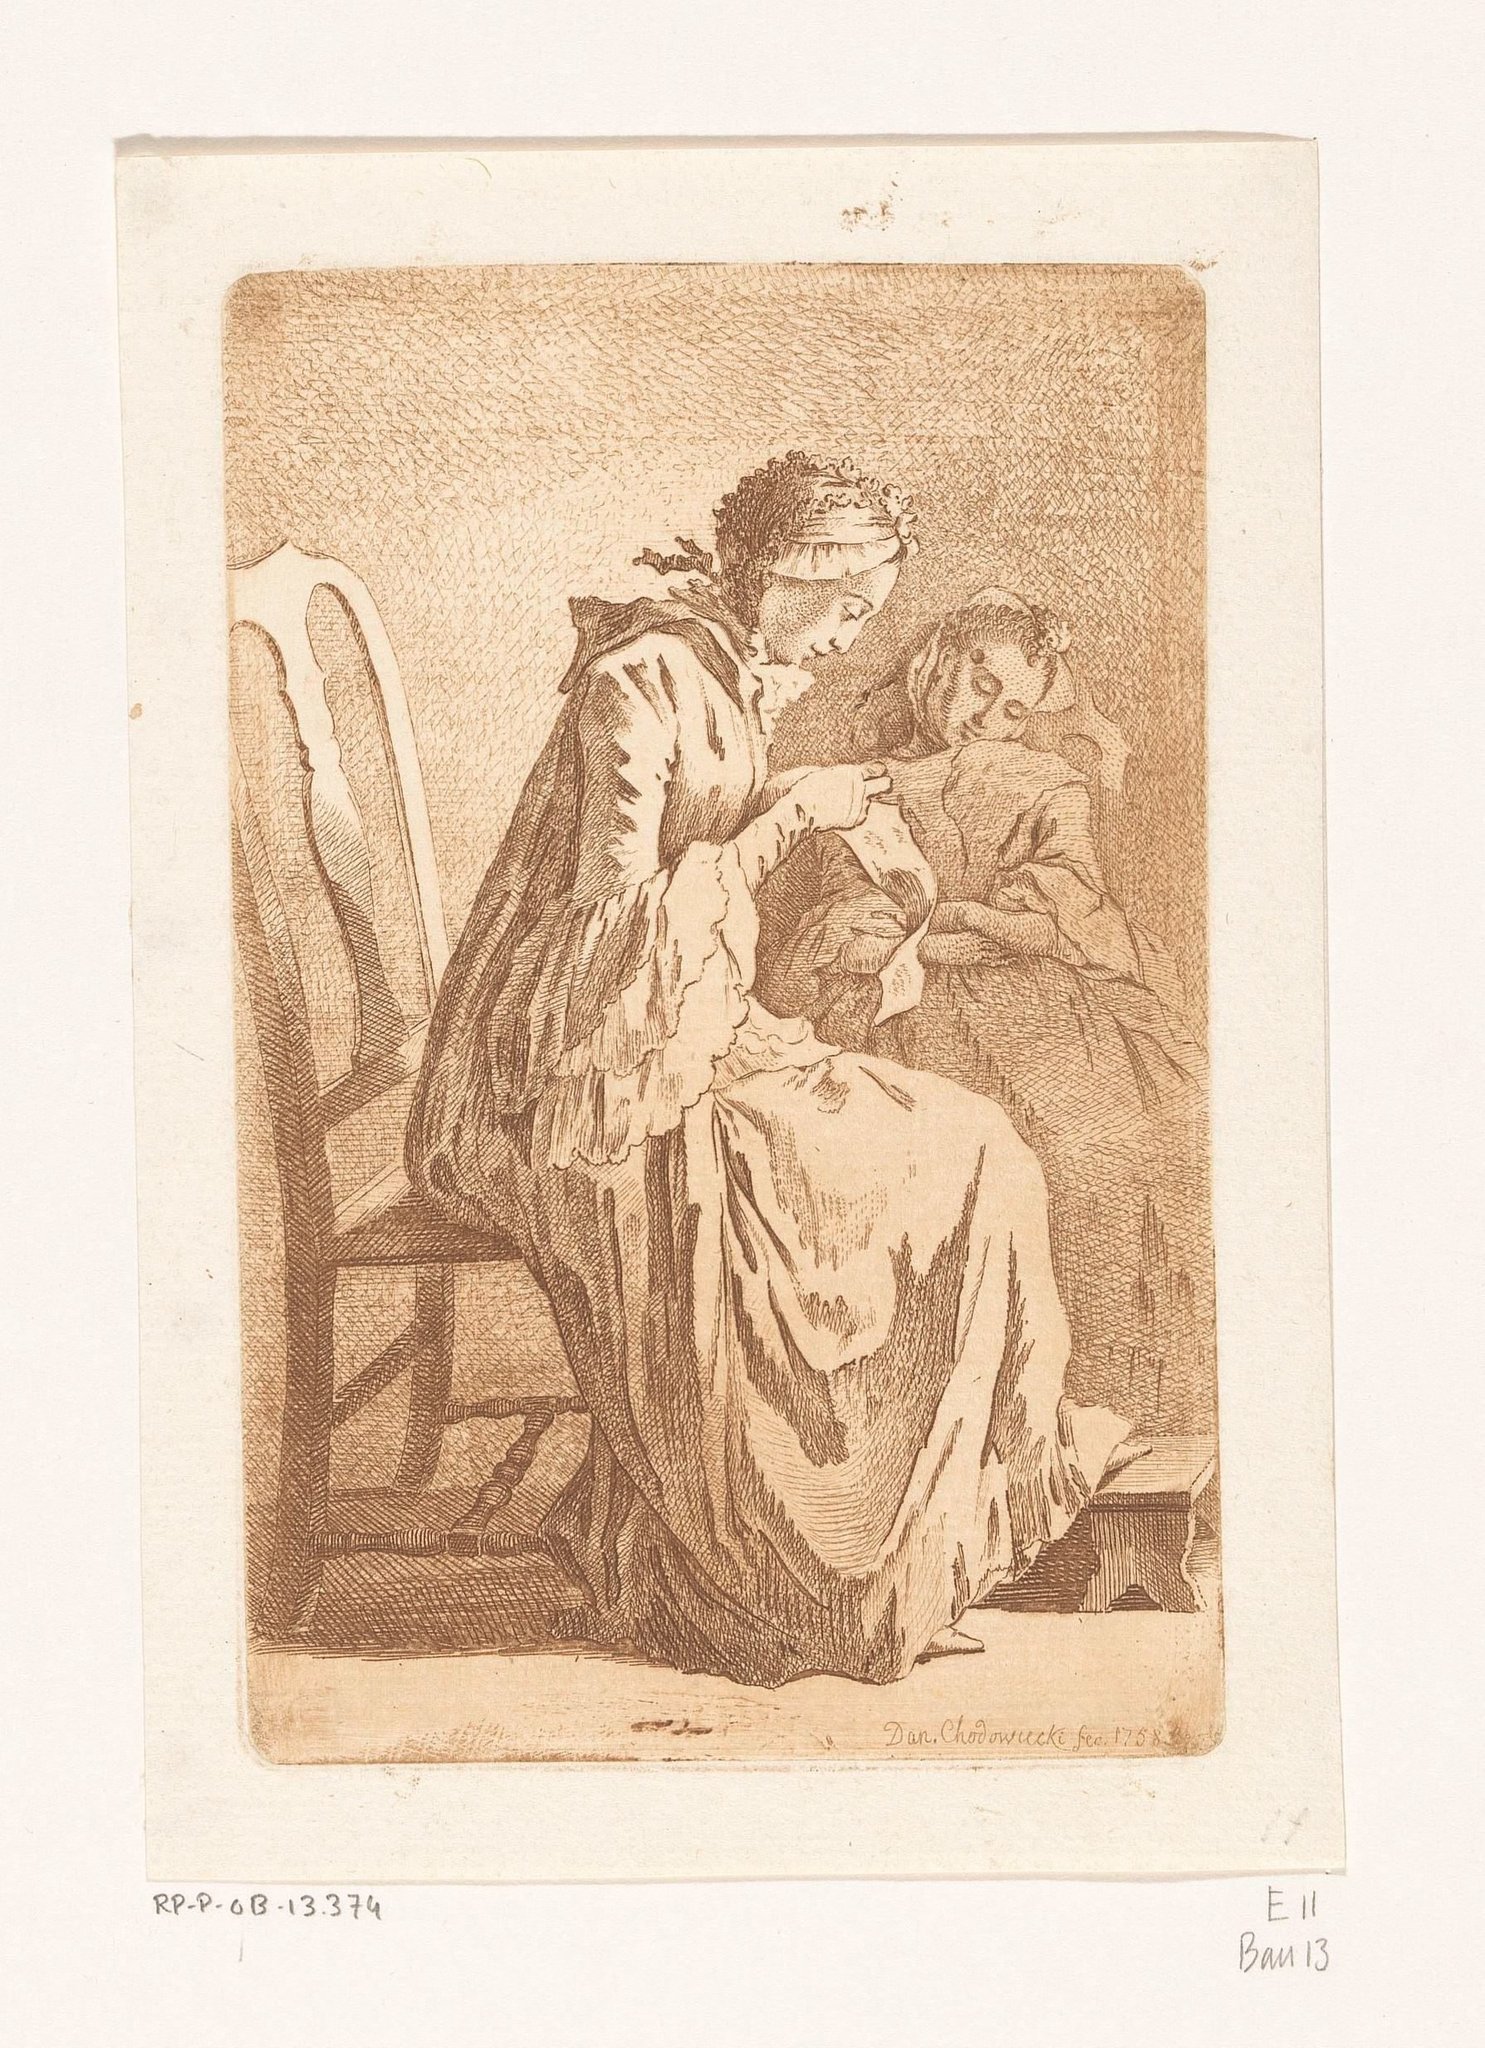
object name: print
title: Twee zittende dames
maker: daniel nikolaus chodowiecki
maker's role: draughtsman, print maker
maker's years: 1726-1801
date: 1758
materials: paper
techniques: etching, intaglio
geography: berlin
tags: historical persons - bb - woman, sewing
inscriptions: collector's mark: Lugt 2228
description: De naaiende vrouw op de voorgrond is Demoiselle Quantin. De slapende vrouw rechts is Johanna Marie, de vrouw van de kunstenaar.